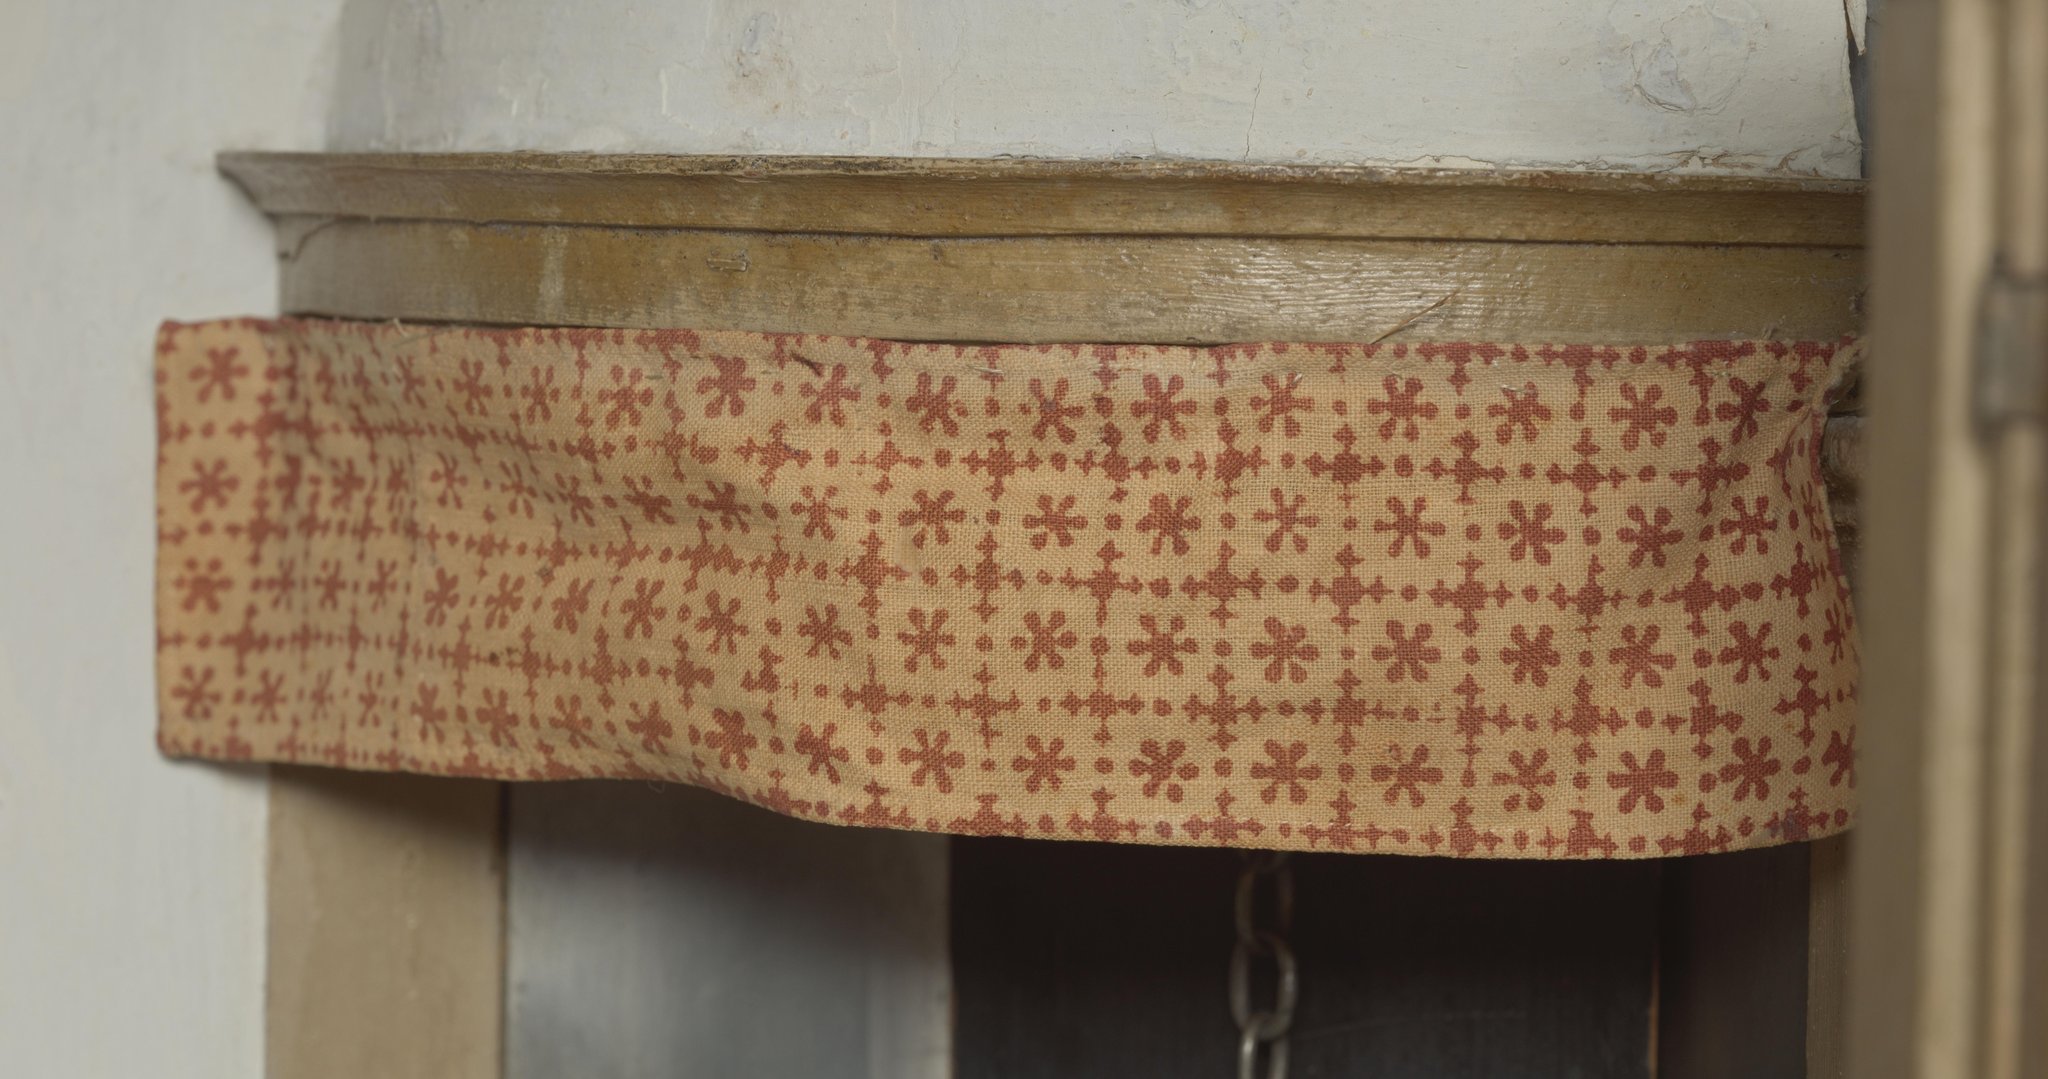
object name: val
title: Schoorsteenval van bedrukt katoen, strak, zonder plooien, genaaid op bandje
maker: Anonymous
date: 1690-1710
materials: cotton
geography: amsterdam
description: Schoorsteenval van bedrukt katoen met een gestileerd motief van gestippelde vierkante vakjes waarin ster, in bruinrood op witte achtergrond. Val (strak, zonder plooien, genaaid op bandje) boven haard.